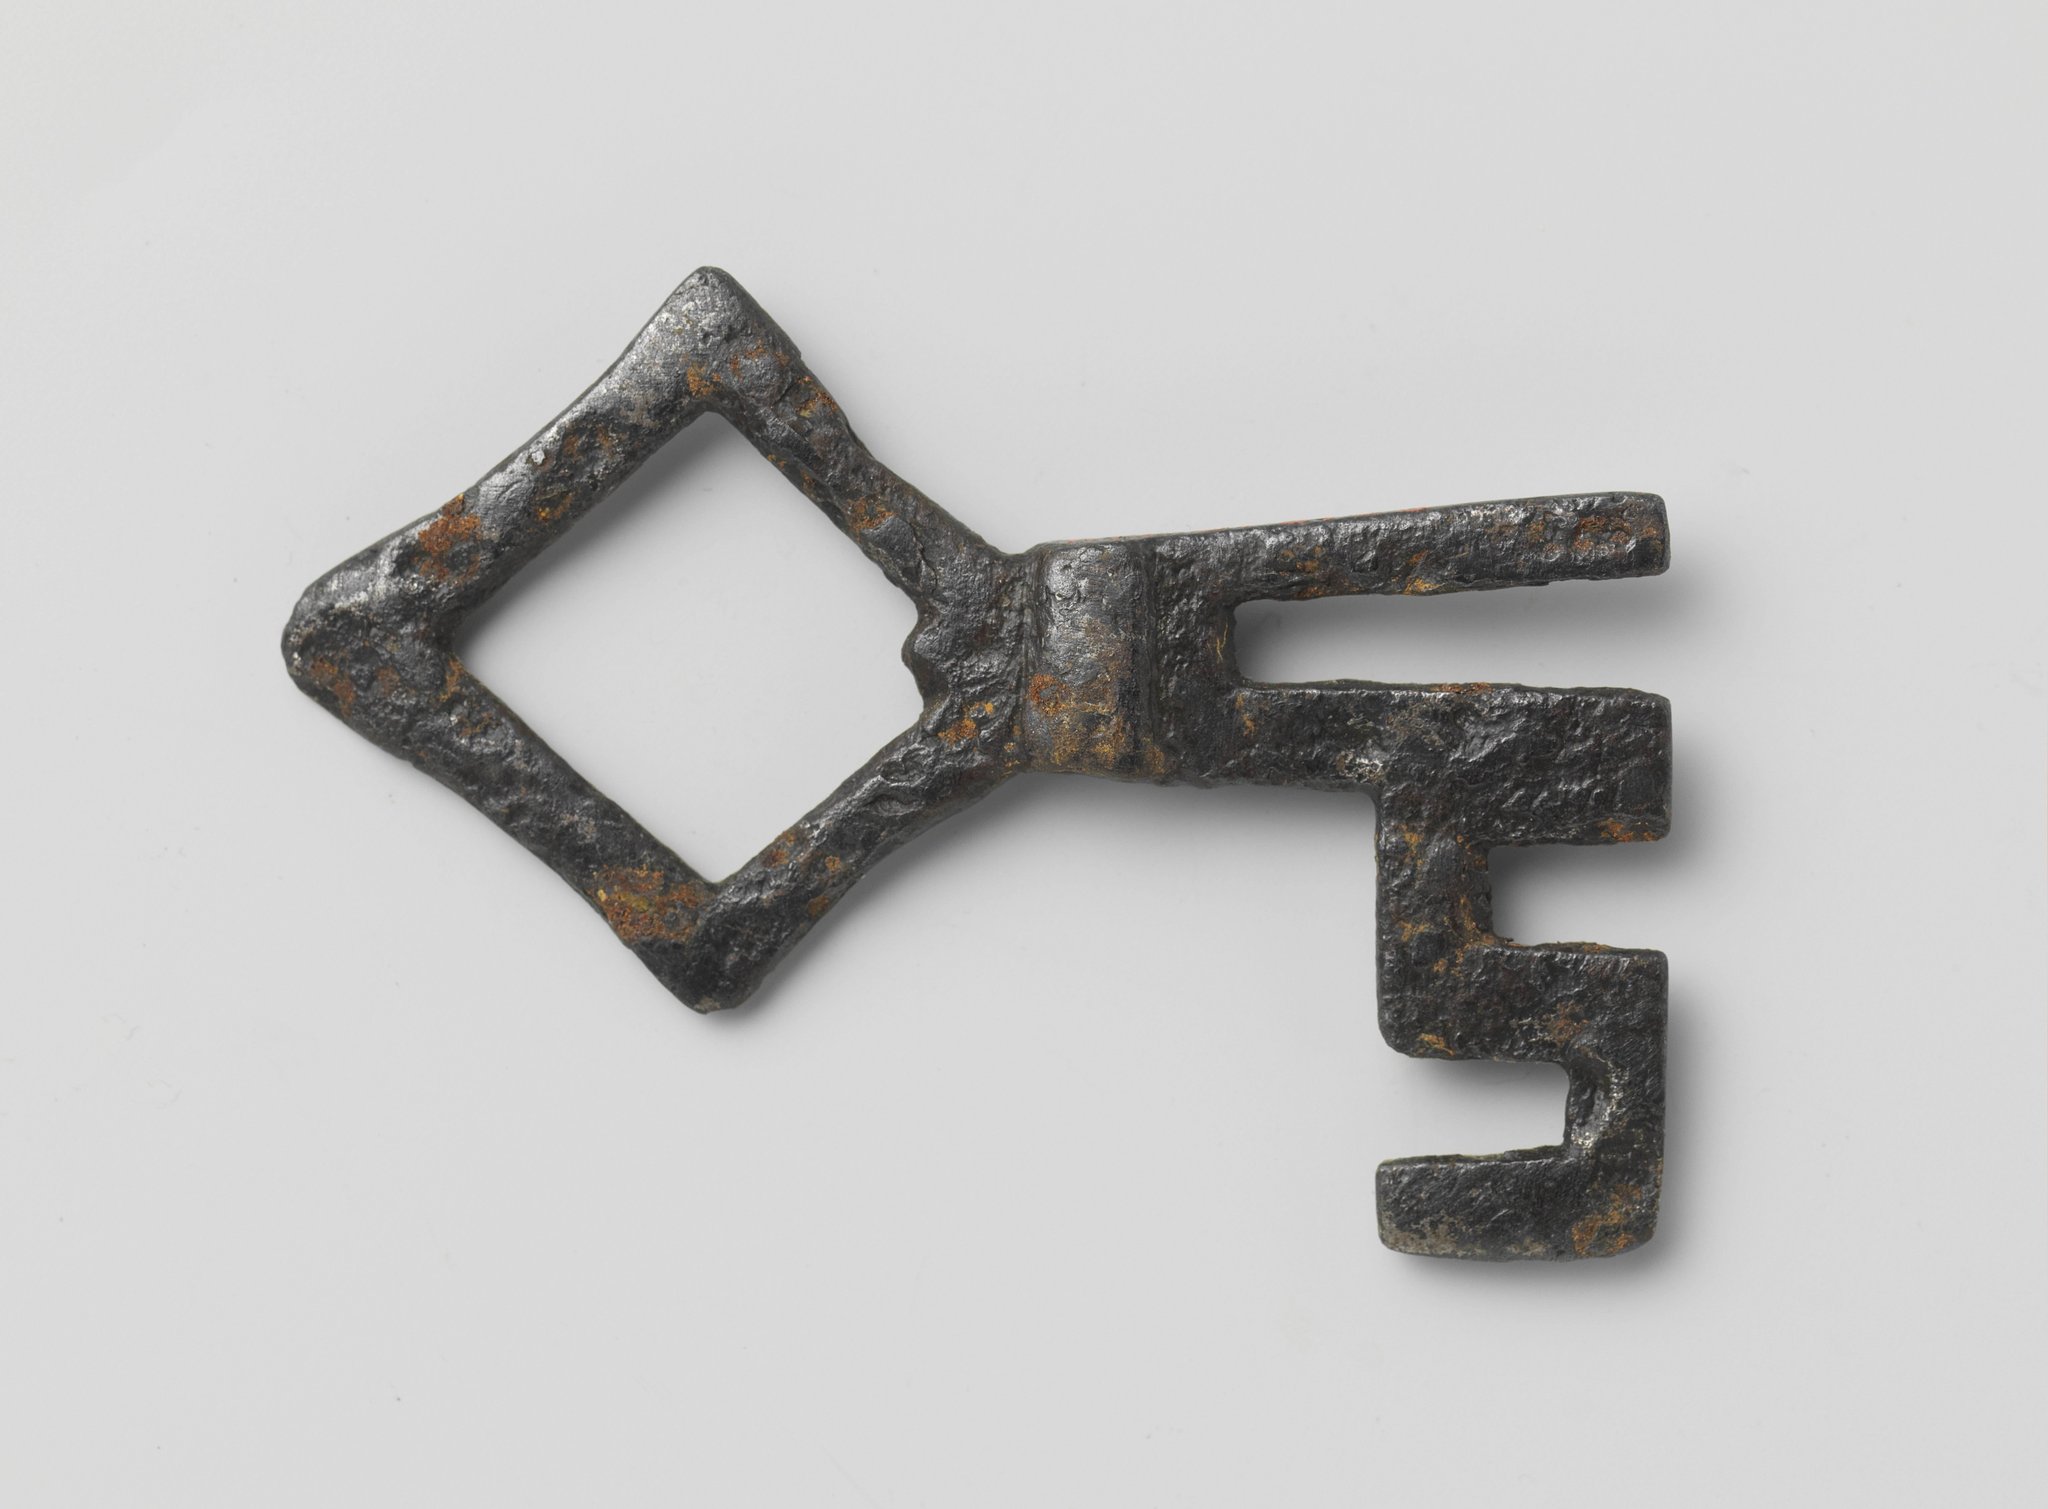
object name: key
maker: Anonymous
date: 1300-1400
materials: iron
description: Sleutel met ruitvormig oog en korte gespleten steel.